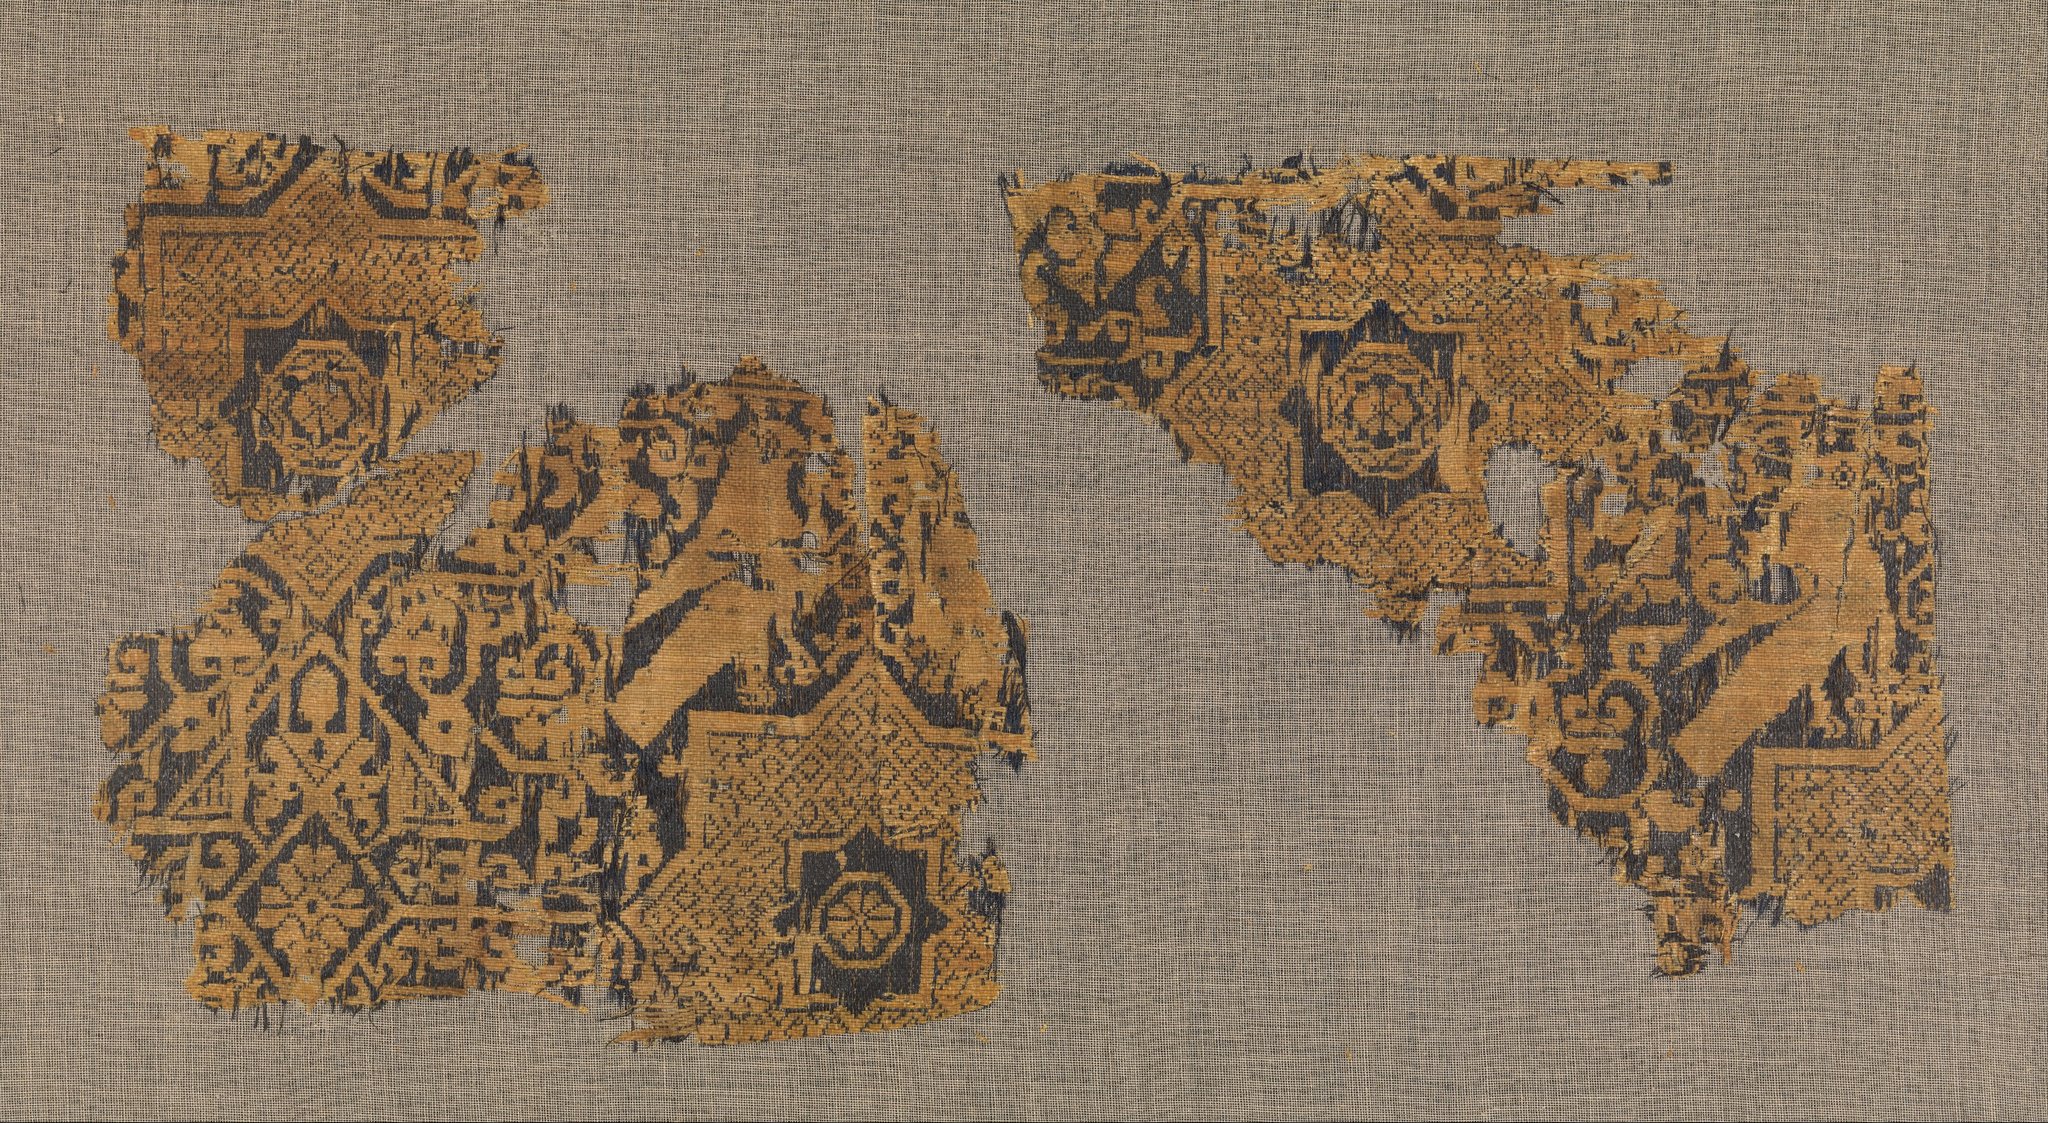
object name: textile fragment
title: Textile with a Pattern of Stars and Birds, Originally from a Cap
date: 1001-1200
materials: silk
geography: iran